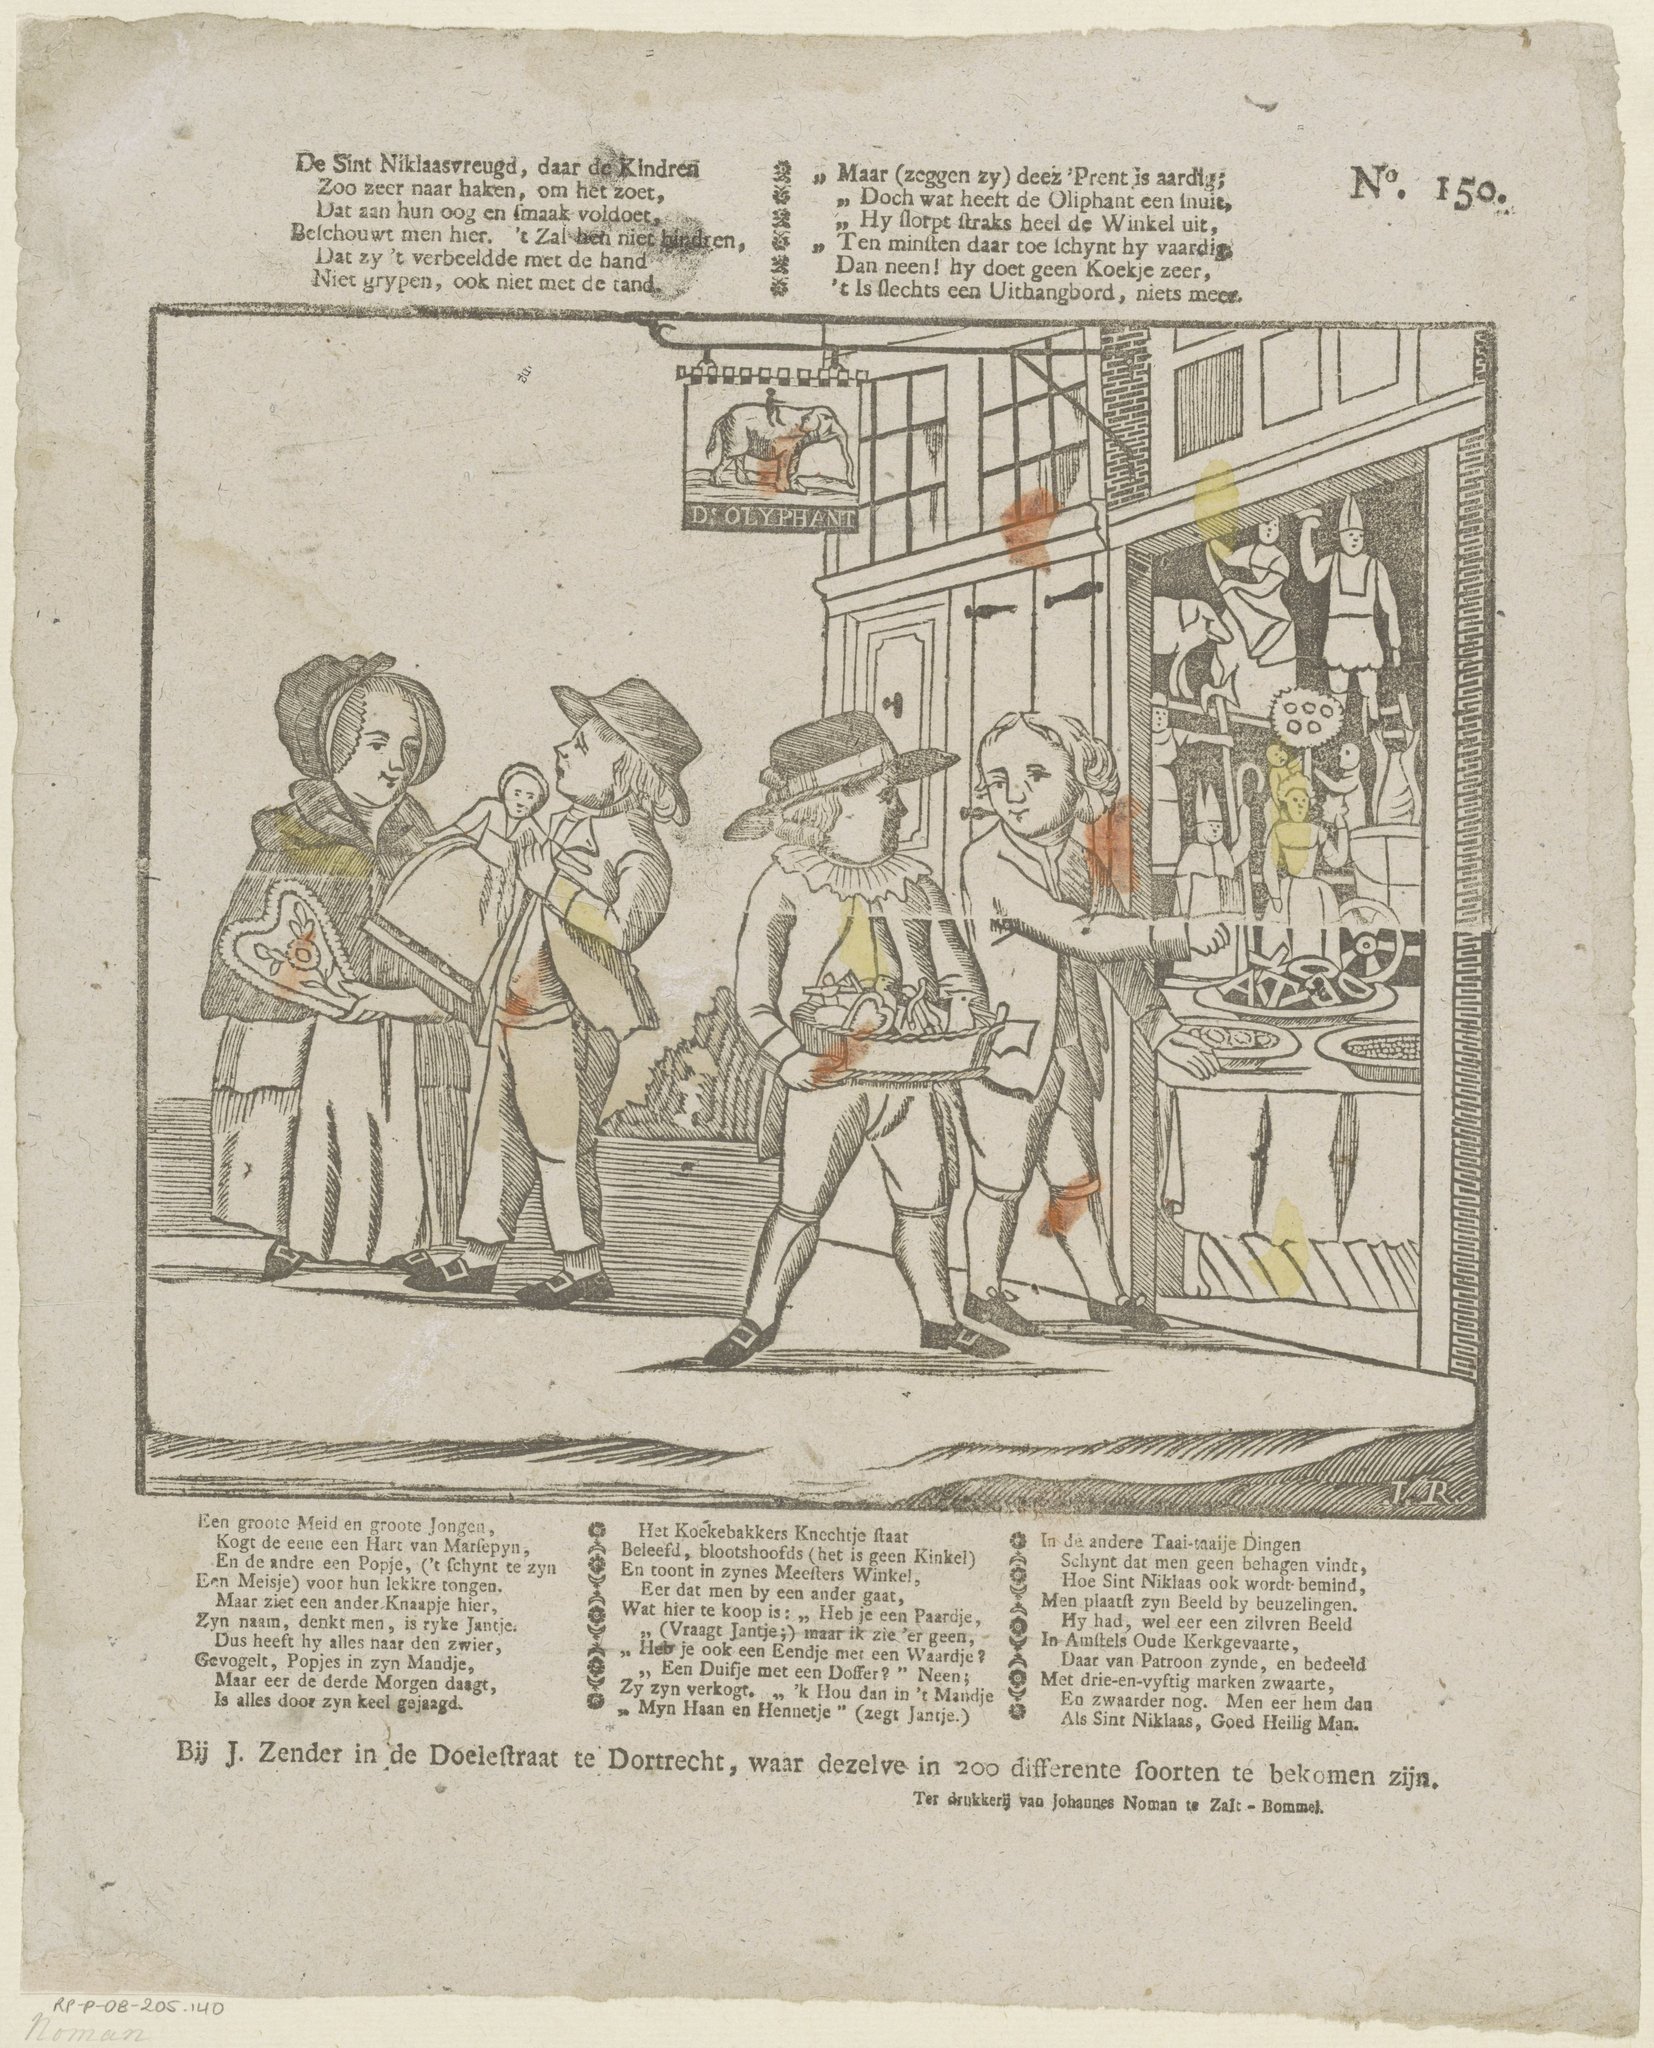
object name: popular print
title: De Sint Niklaasvreugd, daar de kindren / Zo zeer naar haaken, om het zoet [(...)]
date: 1806-1830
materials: paper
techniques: colour, letterpress printing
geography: dordrecht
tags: the bishop nicholas of myra (or bari); possible attributes: anchor, boat, three golden balls (on a book), three purses, three children in a tub, three maidens, child, sugar-candy, (playing with) toys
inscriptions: collector's mark: Lugt 2760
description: Blad met een grote voorstelling van kinderen voor een winkel waar snoepgoed en speelgoed voor het Sinterklaasfeest verkocht wordt. Onder de afbeelding een vers in drie kolommen. Genummerd rechtsboven: No 150.